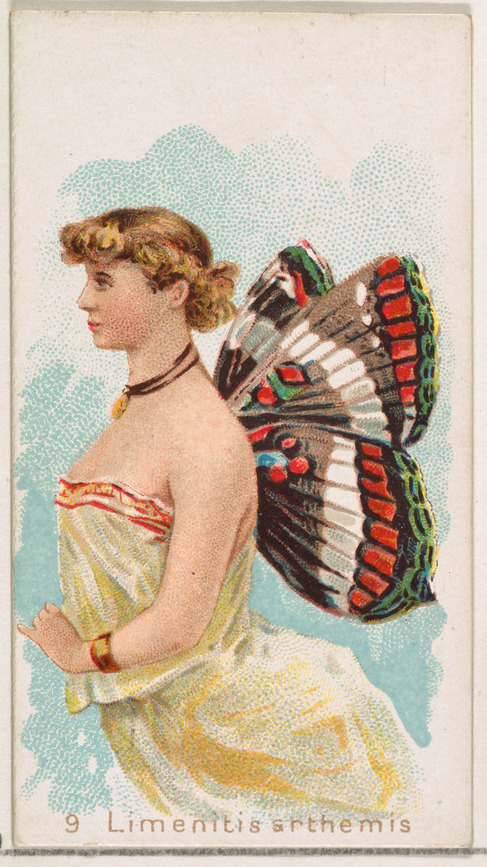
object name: print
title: Card 9, Limenitis Arthemis, from the Butterflies series (N183) issued by Wm. S. Kimball & Co.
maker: william s. kimball & company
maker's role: publisher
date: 1888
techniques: color lithograph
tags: profiles,women,butterflies